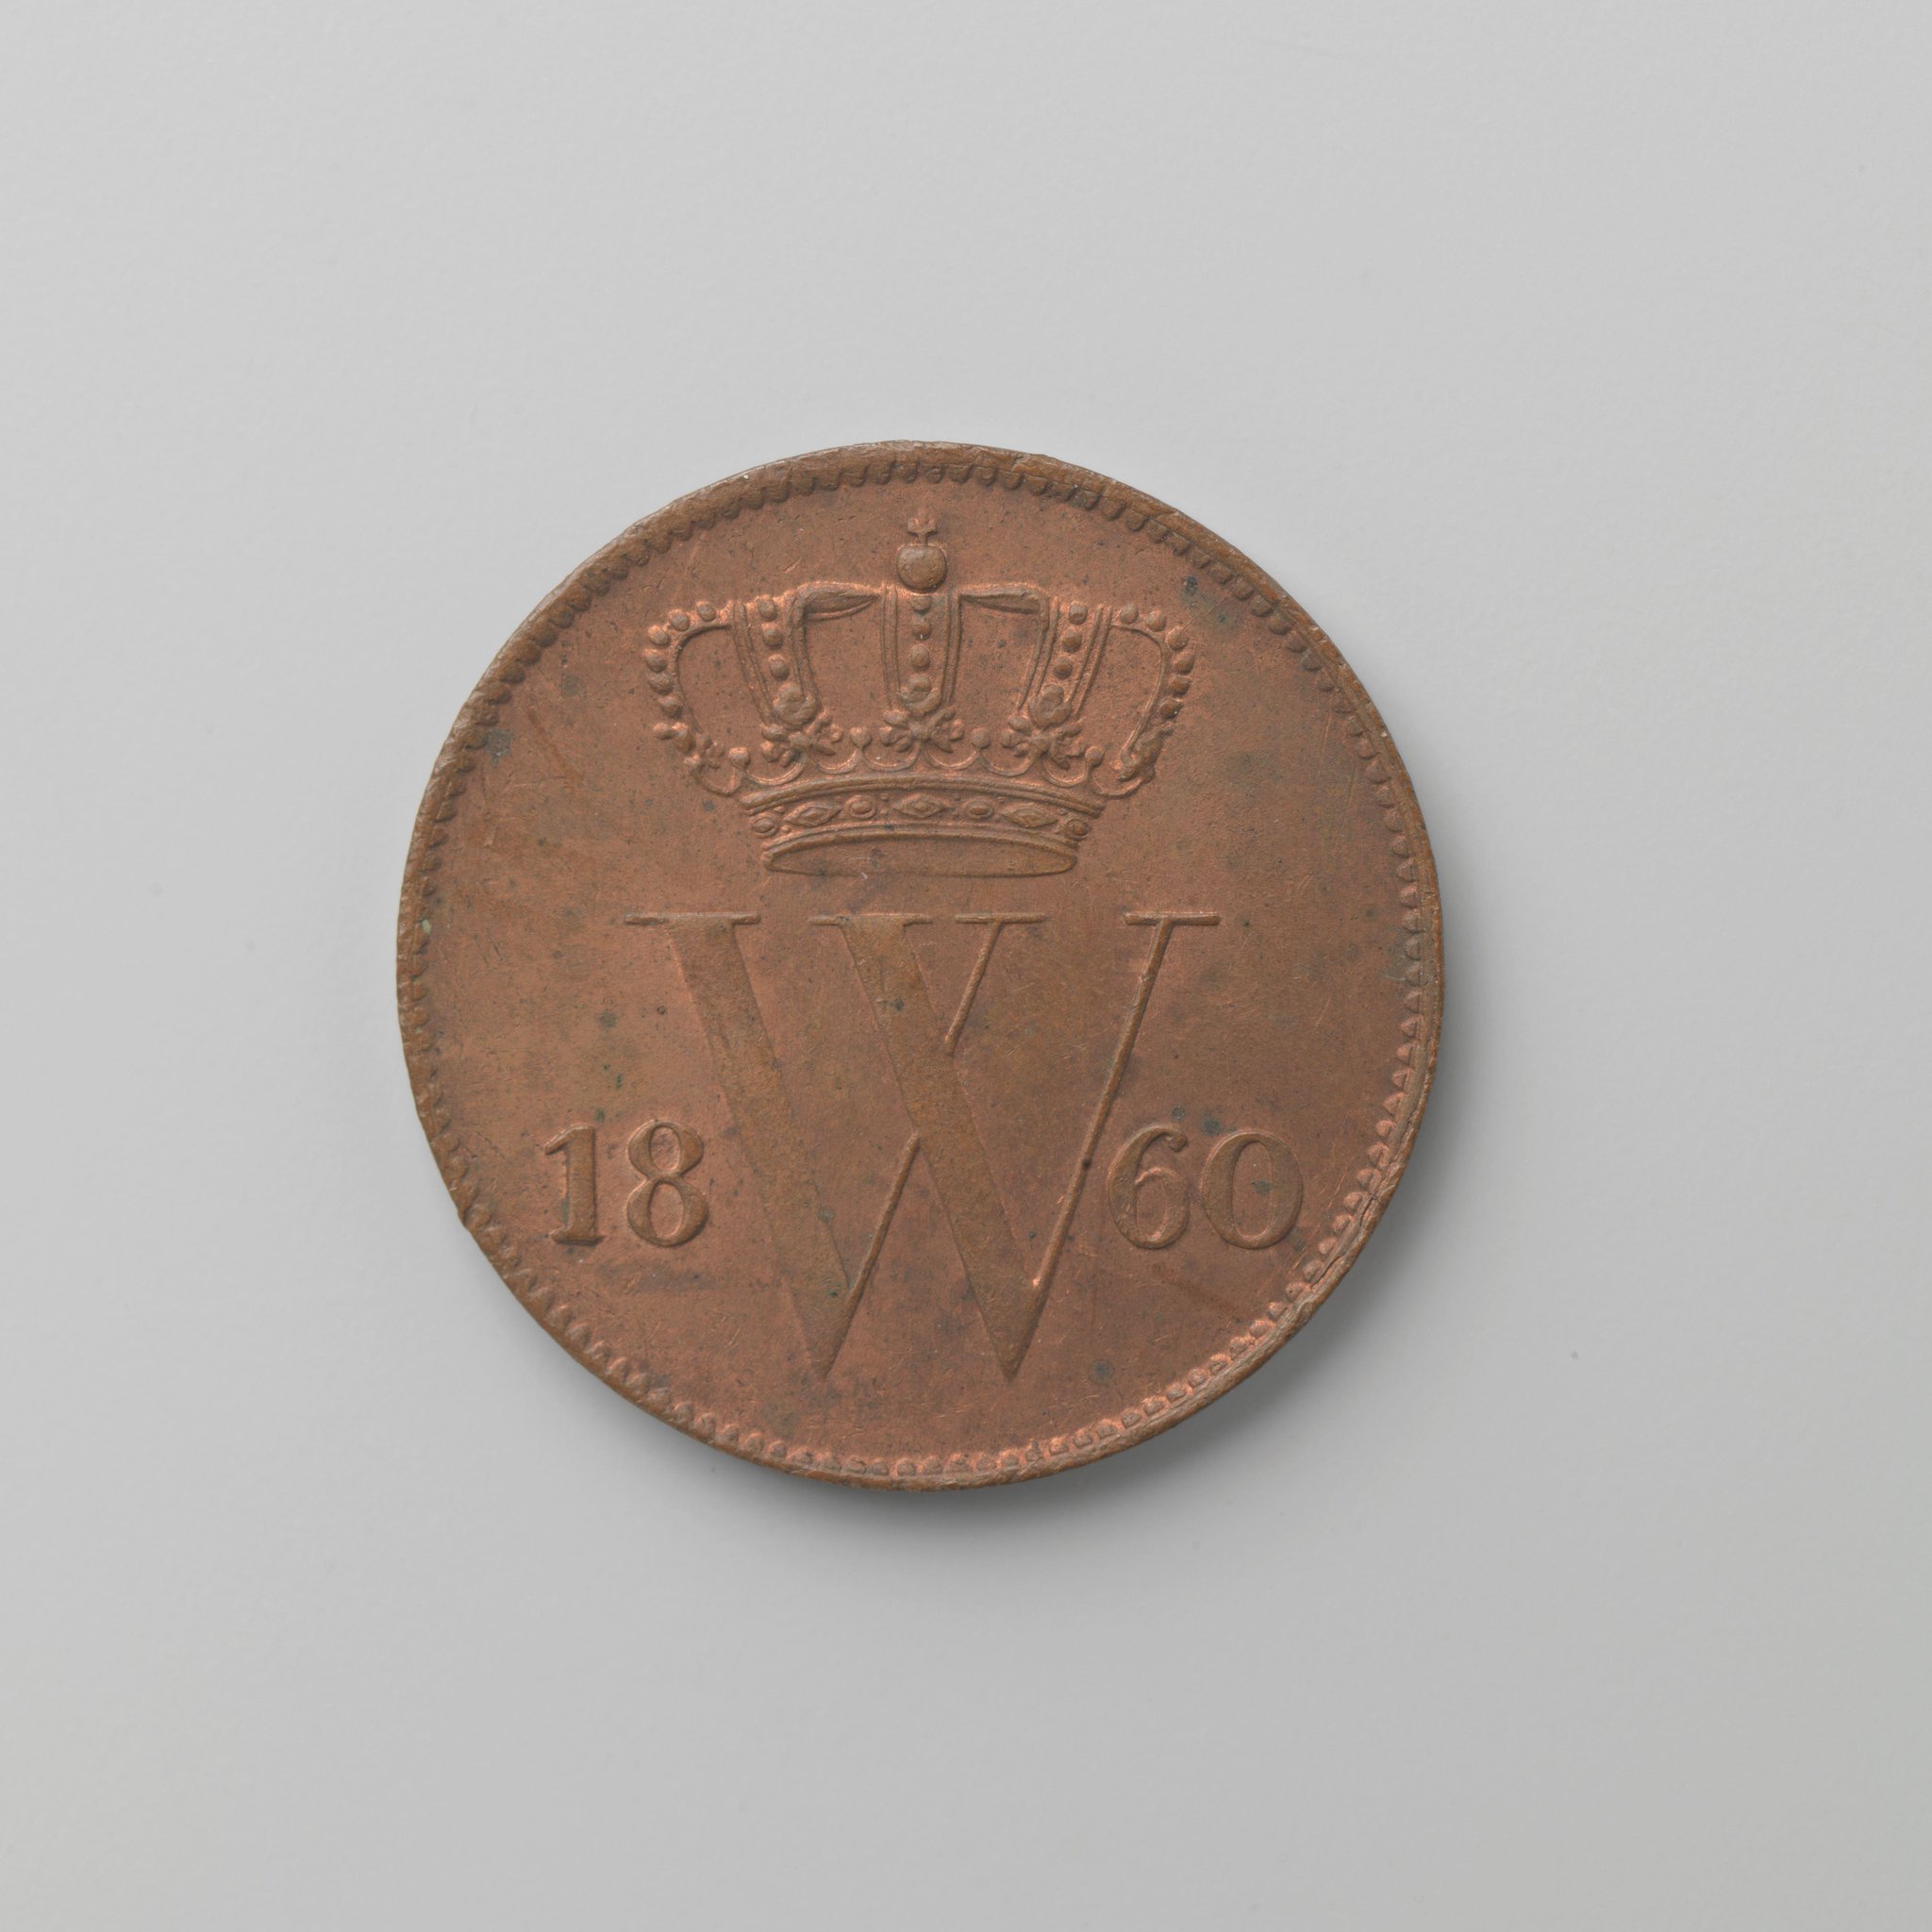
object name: coin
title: Nederlandse cent, 1860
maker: willem iii (koning der nederlanden)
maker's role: koning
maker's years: 1817-1890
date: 1860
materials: copper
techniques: striking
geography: utrecht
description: Koperen munt. Voorzijde: tussen jaartal gekroonde rechte letter W. Keerzijde: tussen waarde-aanduiding 1 C. gekroond rijkswapenschild. Gladde rand.